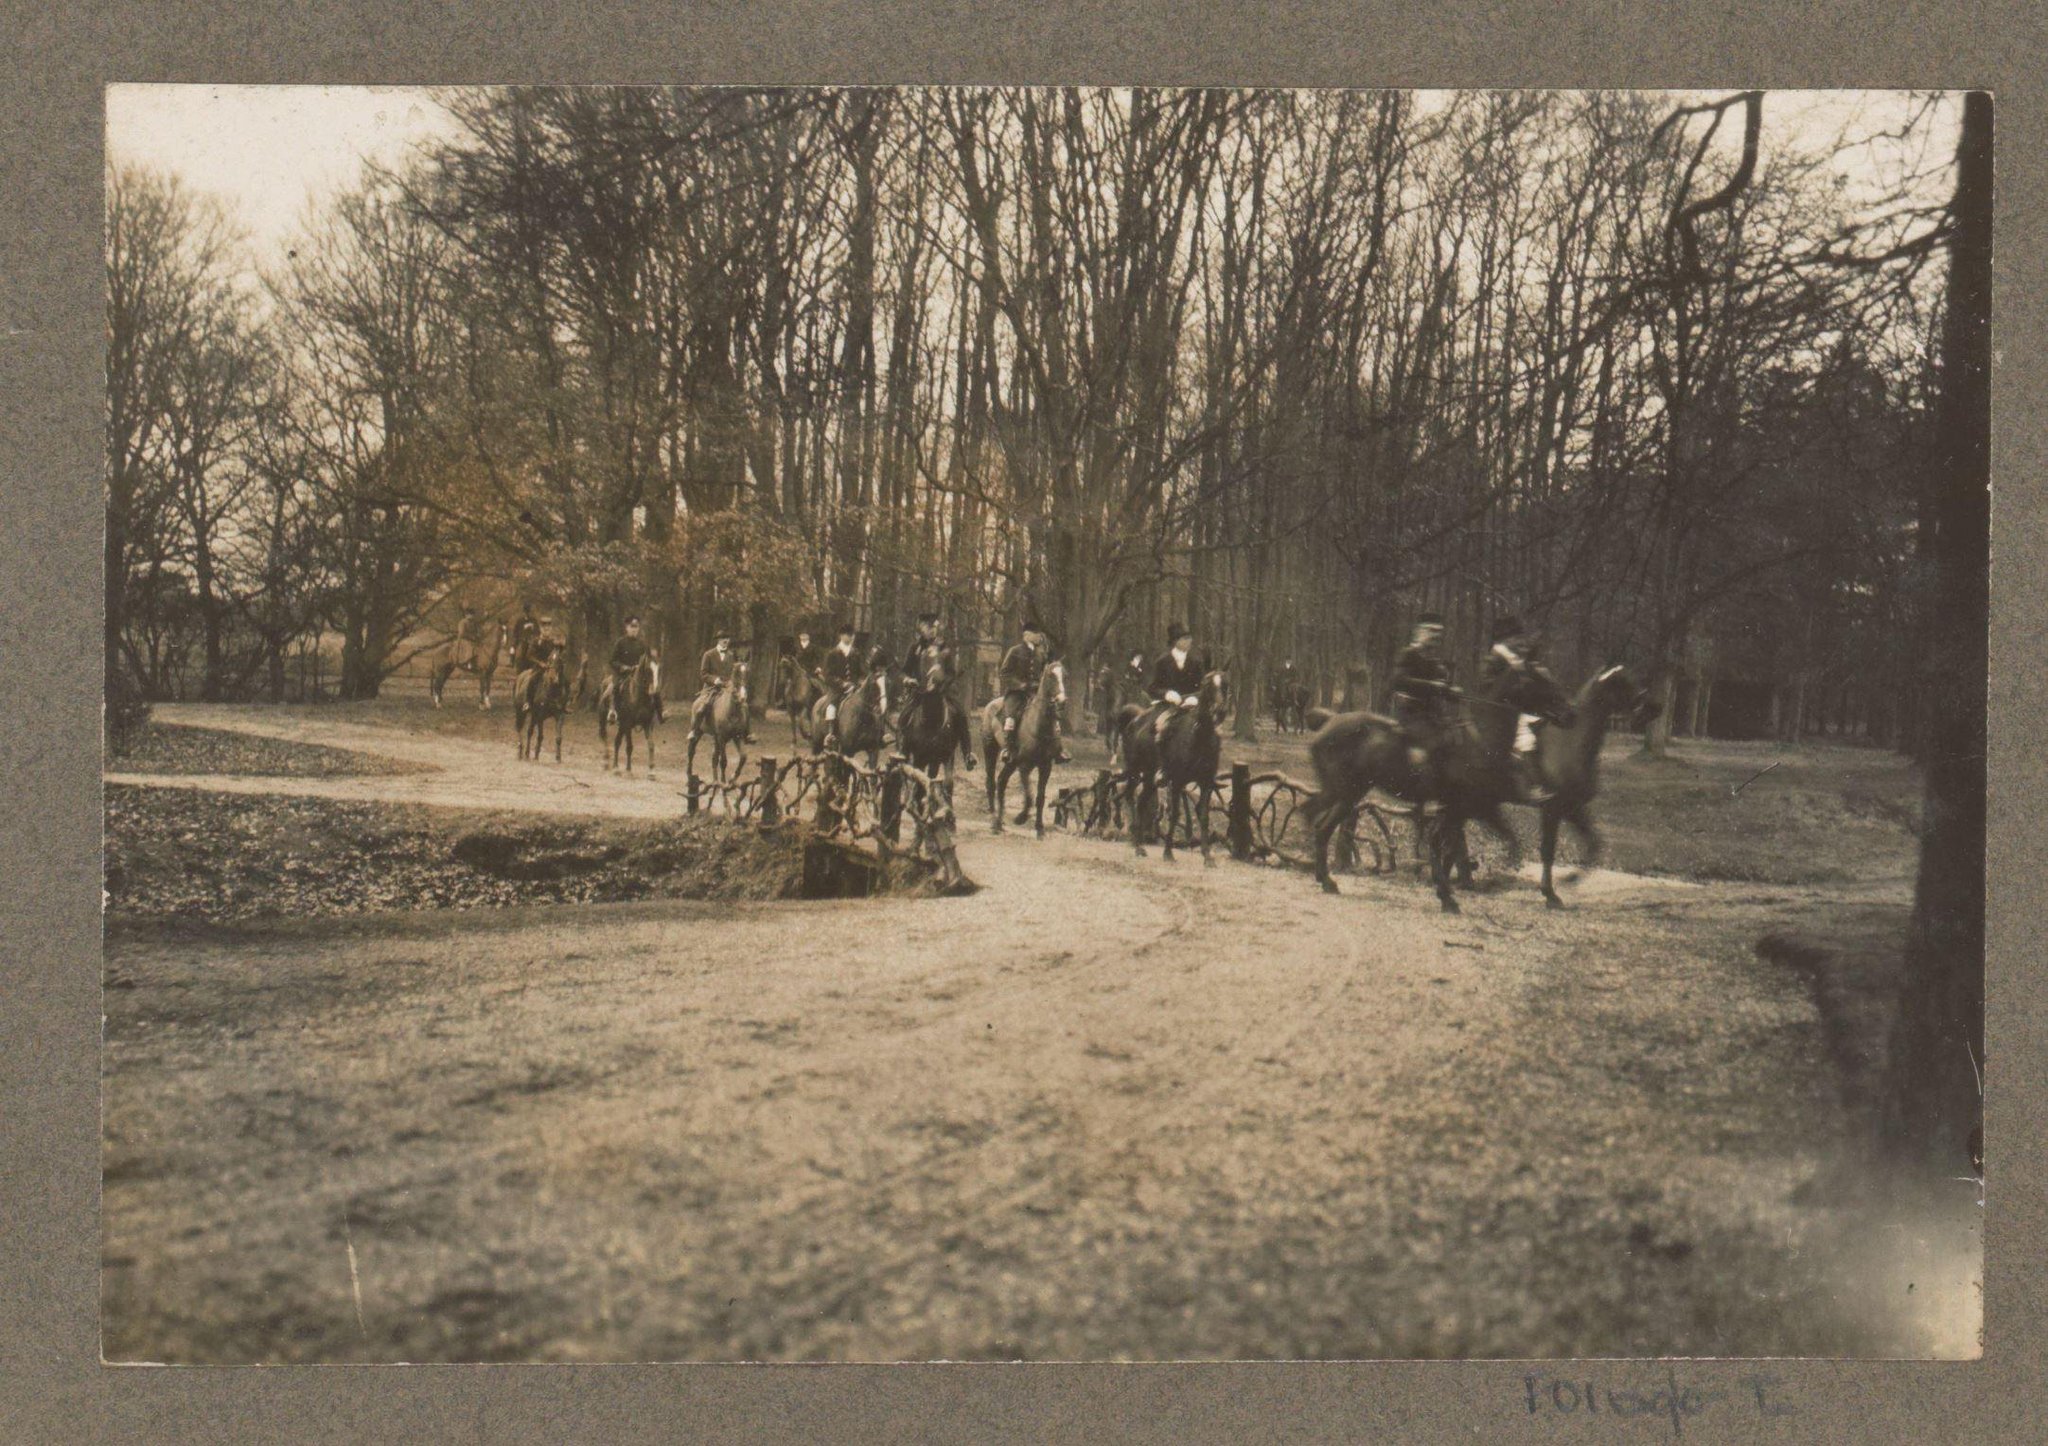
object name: photograph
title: Ruitertafereel op Koninklijke Houtvesterij Het Loo: ruiters bij een brug op een bosweg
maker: Anonymous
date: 1900-1925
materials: photographic support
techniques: gelatin silver print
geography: het loo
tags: riding a horse, ass, or mule; rider, horseman, hunting, chase, hunting-ground, forest path or lane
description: Onderdeel van Fotoalbum van de heer Brams, opperhoutvester van koningin Wilhelmina op Koninklijke Houtvesterij Het Loo.